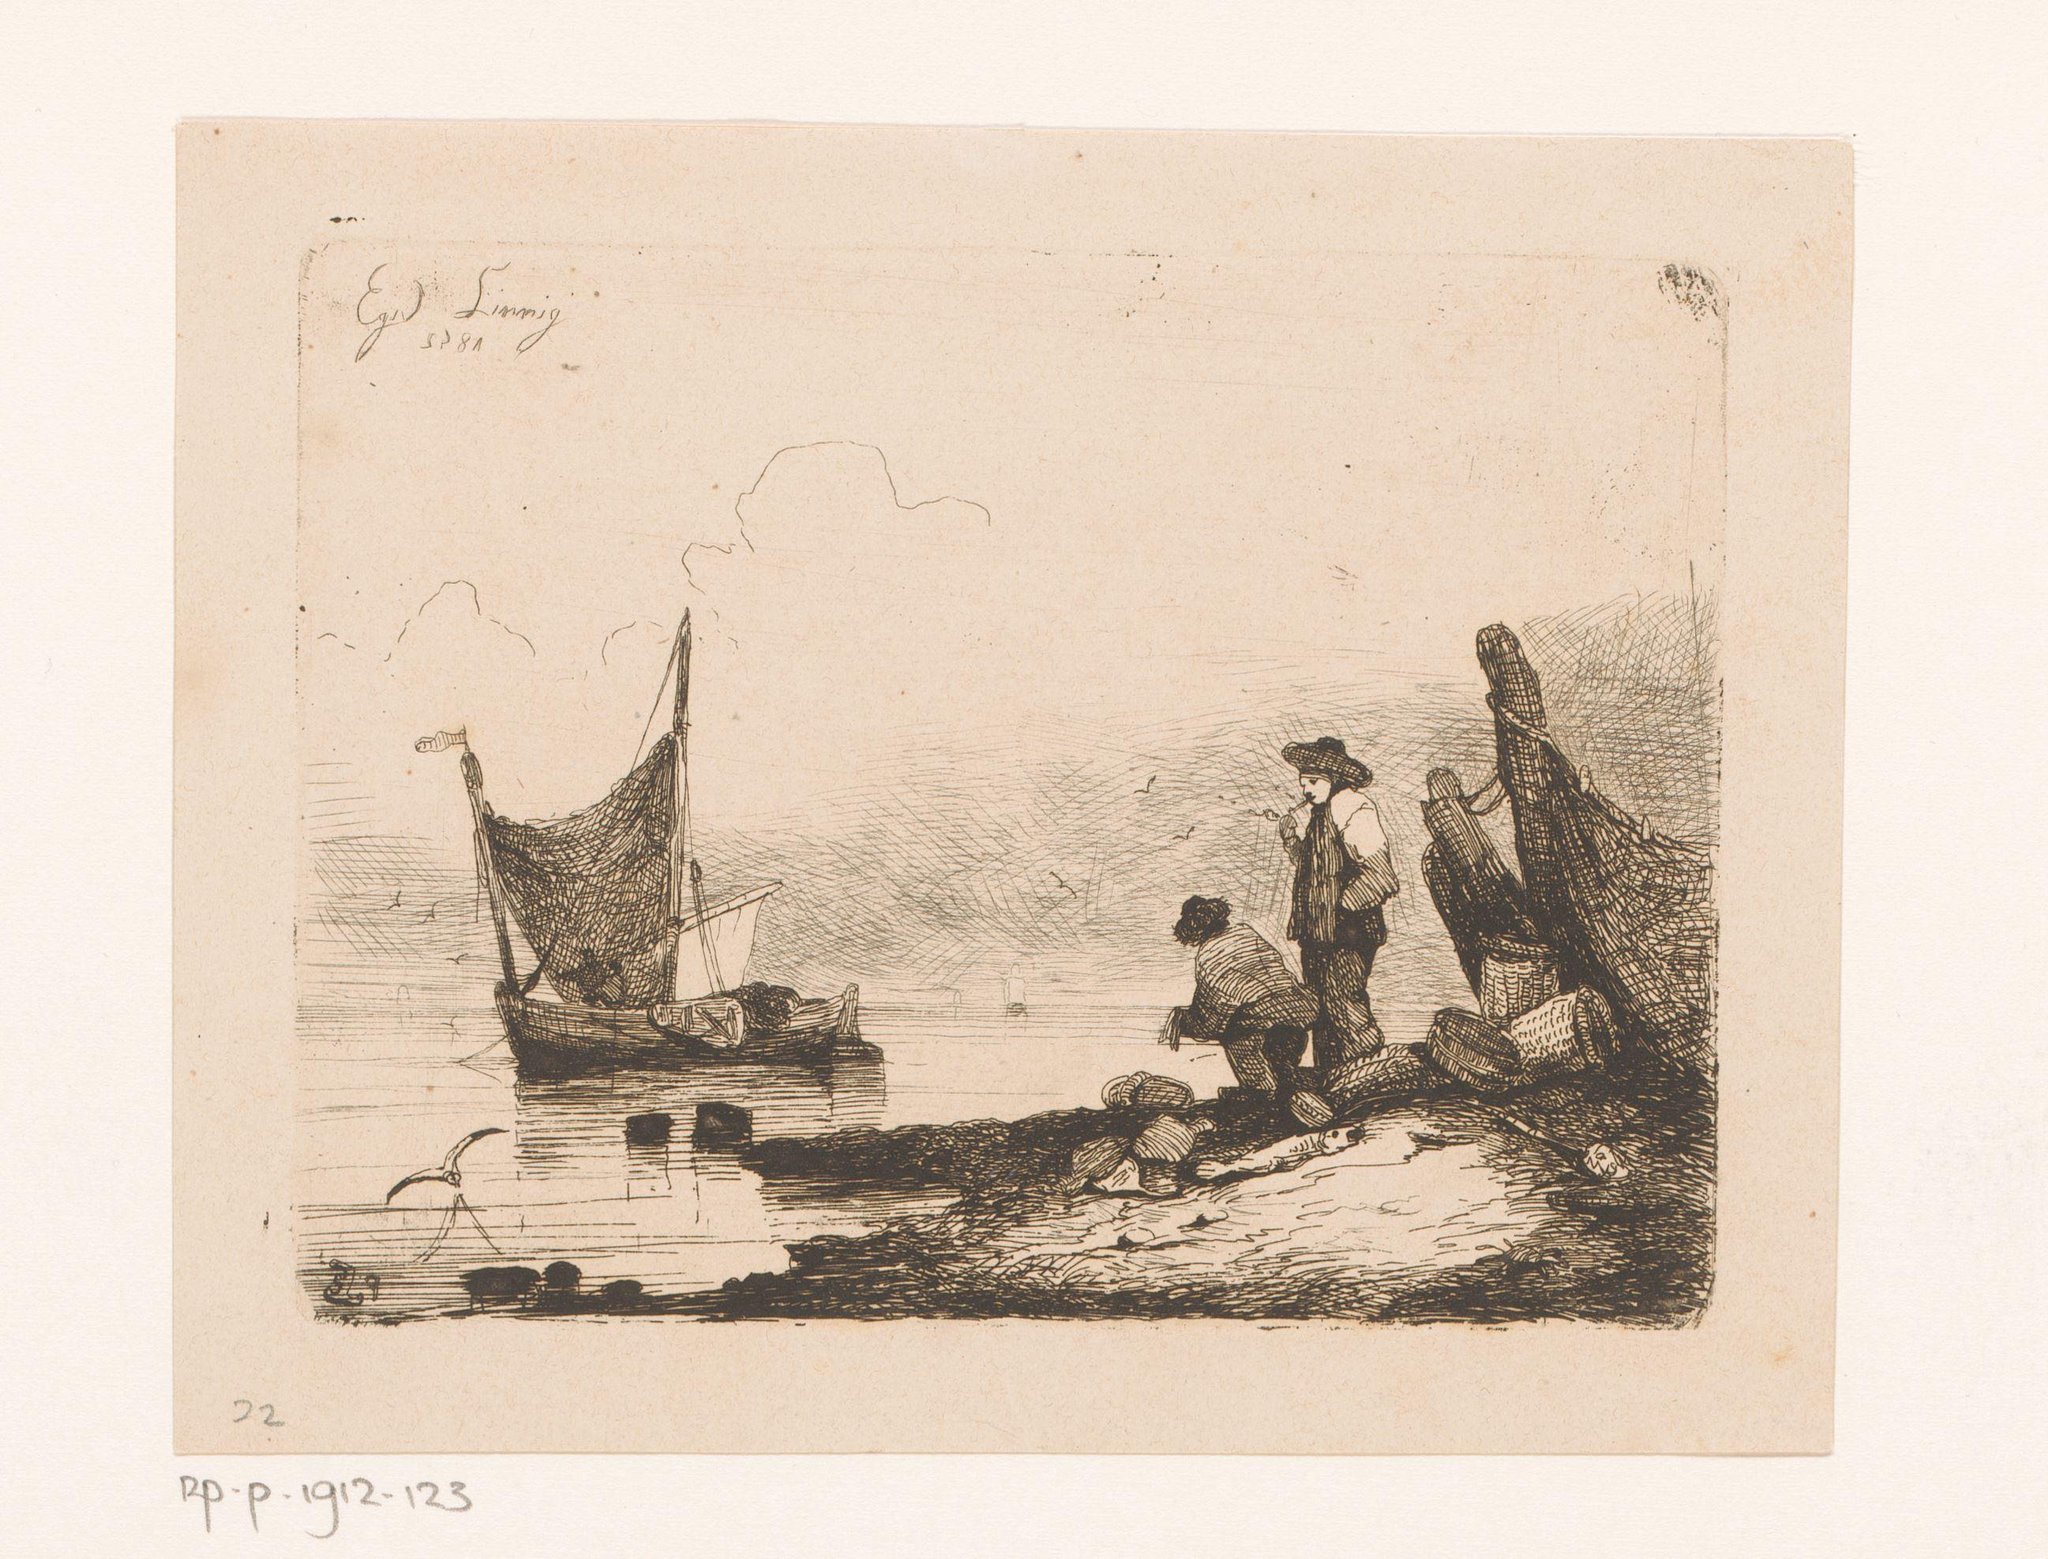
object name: print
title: Inspectie van de visvangst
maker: egidius linnig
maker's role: draughtsman, print maker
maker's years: 1821-1860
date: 1842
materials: paper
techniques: etching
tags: sailing-ship, sailing-boat, sea and coastal fishery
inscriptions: collector's mark: Lugt 2228, collector's mark: Lugt 1485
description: Twee personen staan op een oever, de een rookt een pijp terwijl de ander een vis vast heeft. Op de achtergrond een vissersboot.